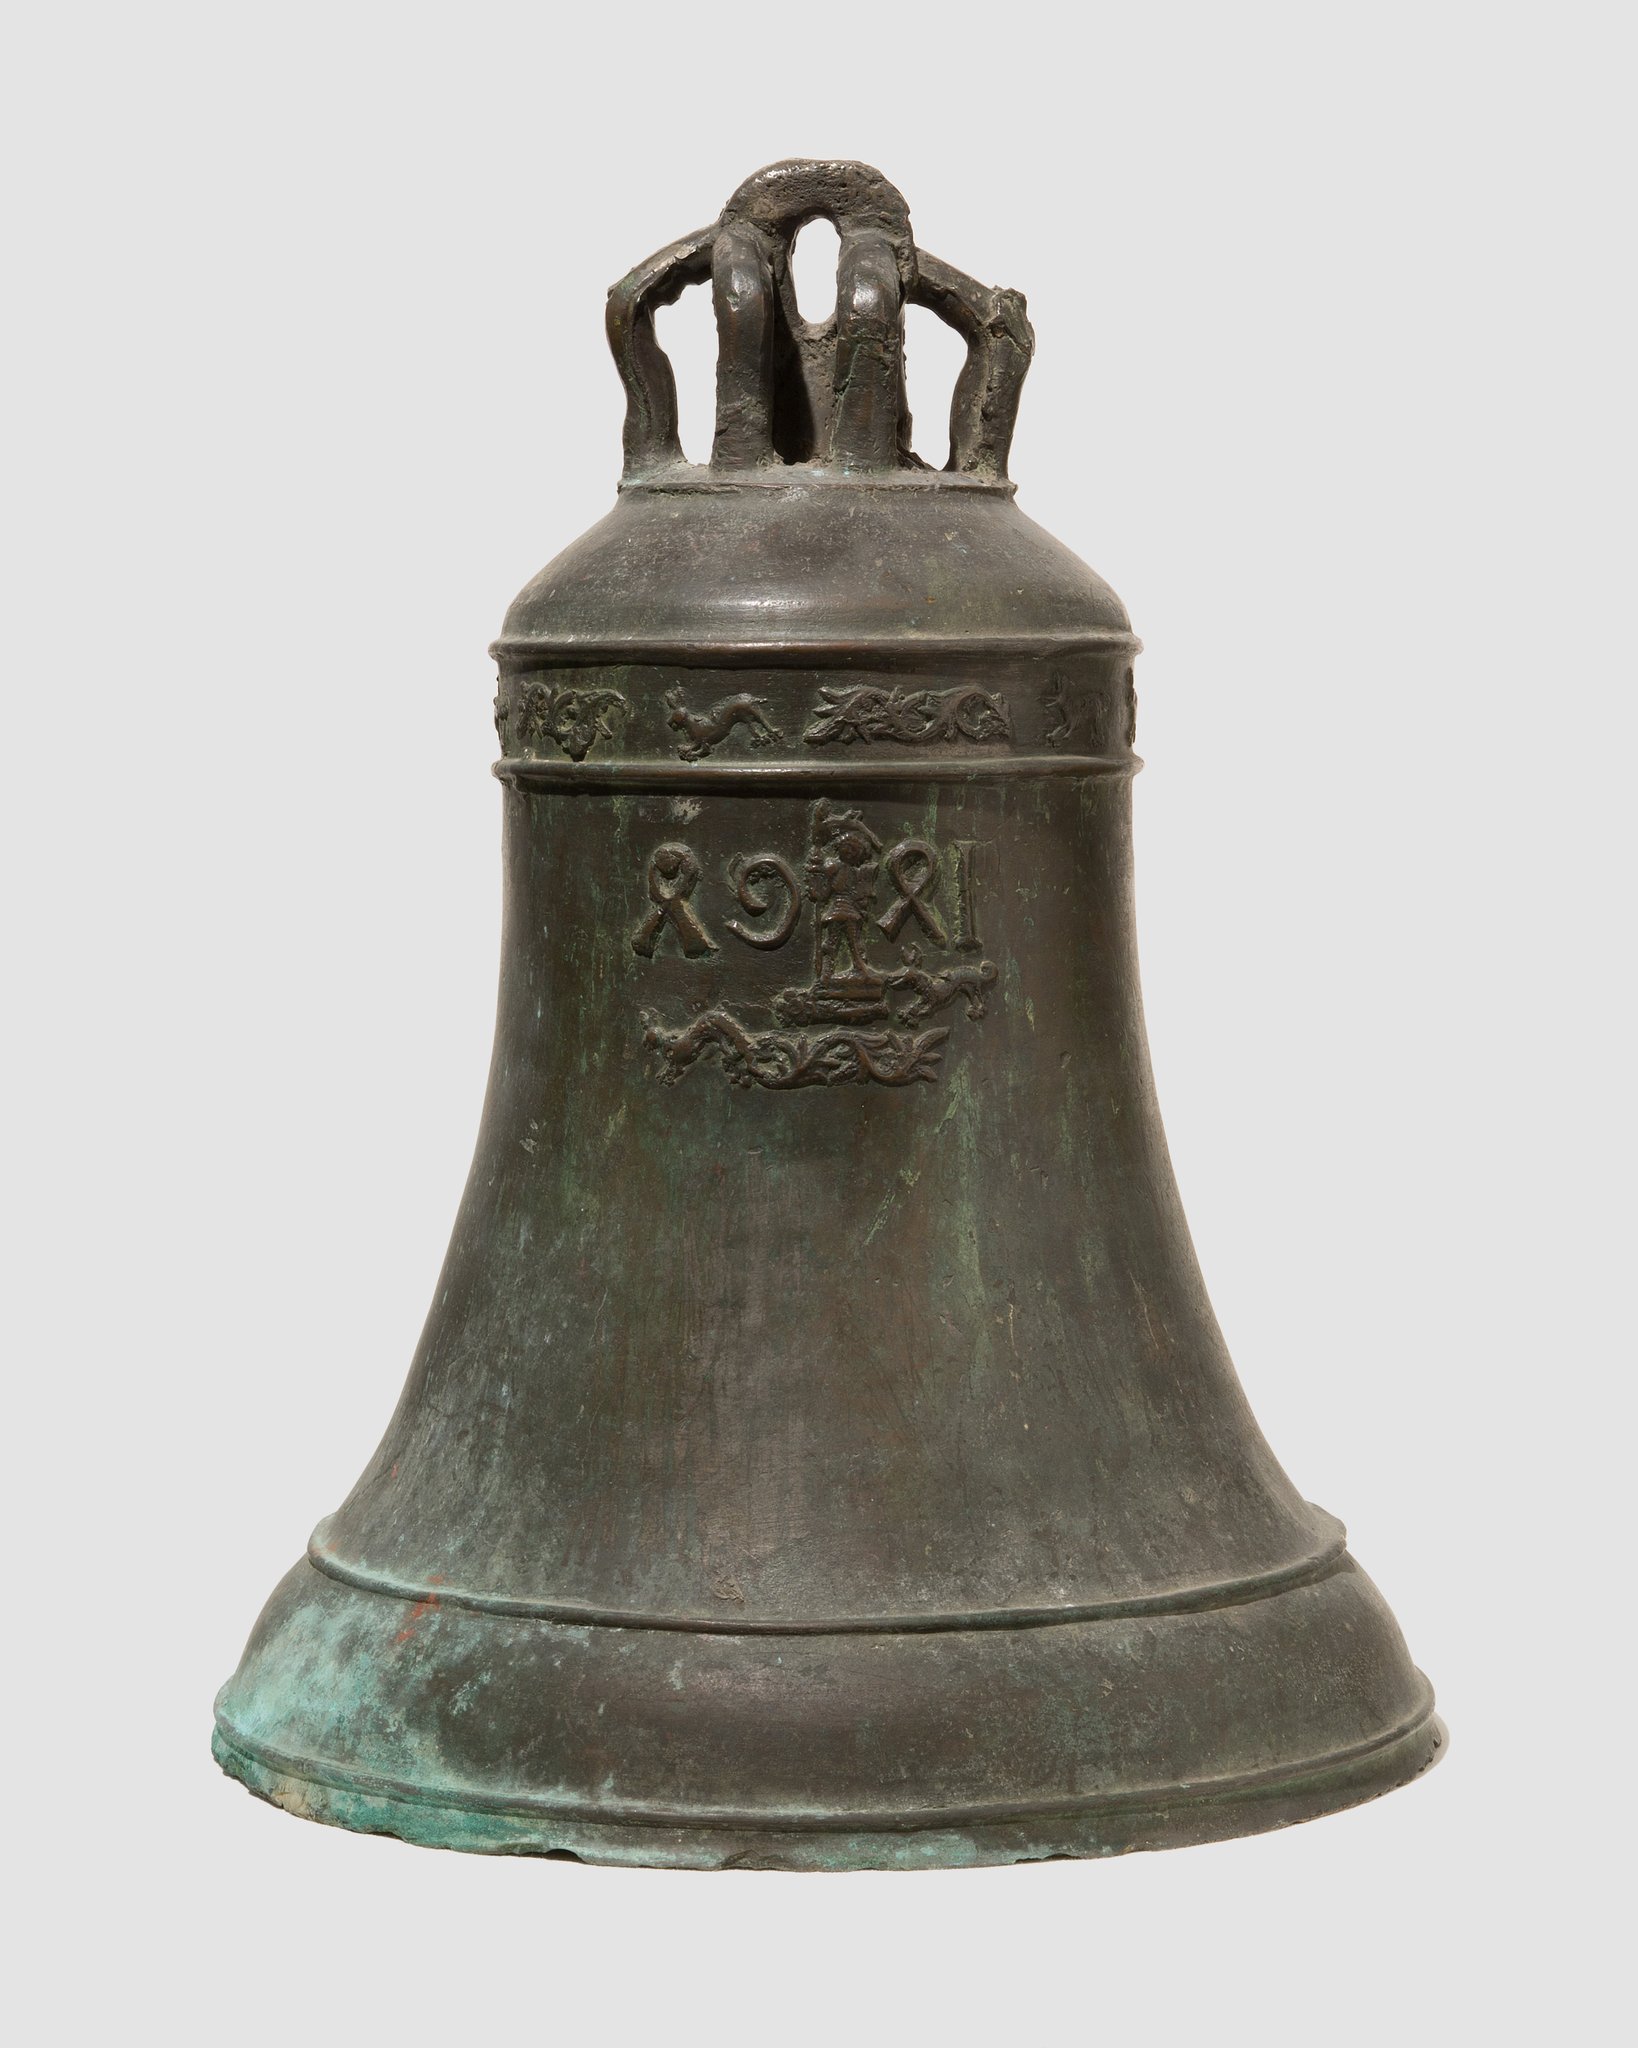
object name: bell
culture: austrian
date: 1494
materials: bronze, patina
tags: musical instruments